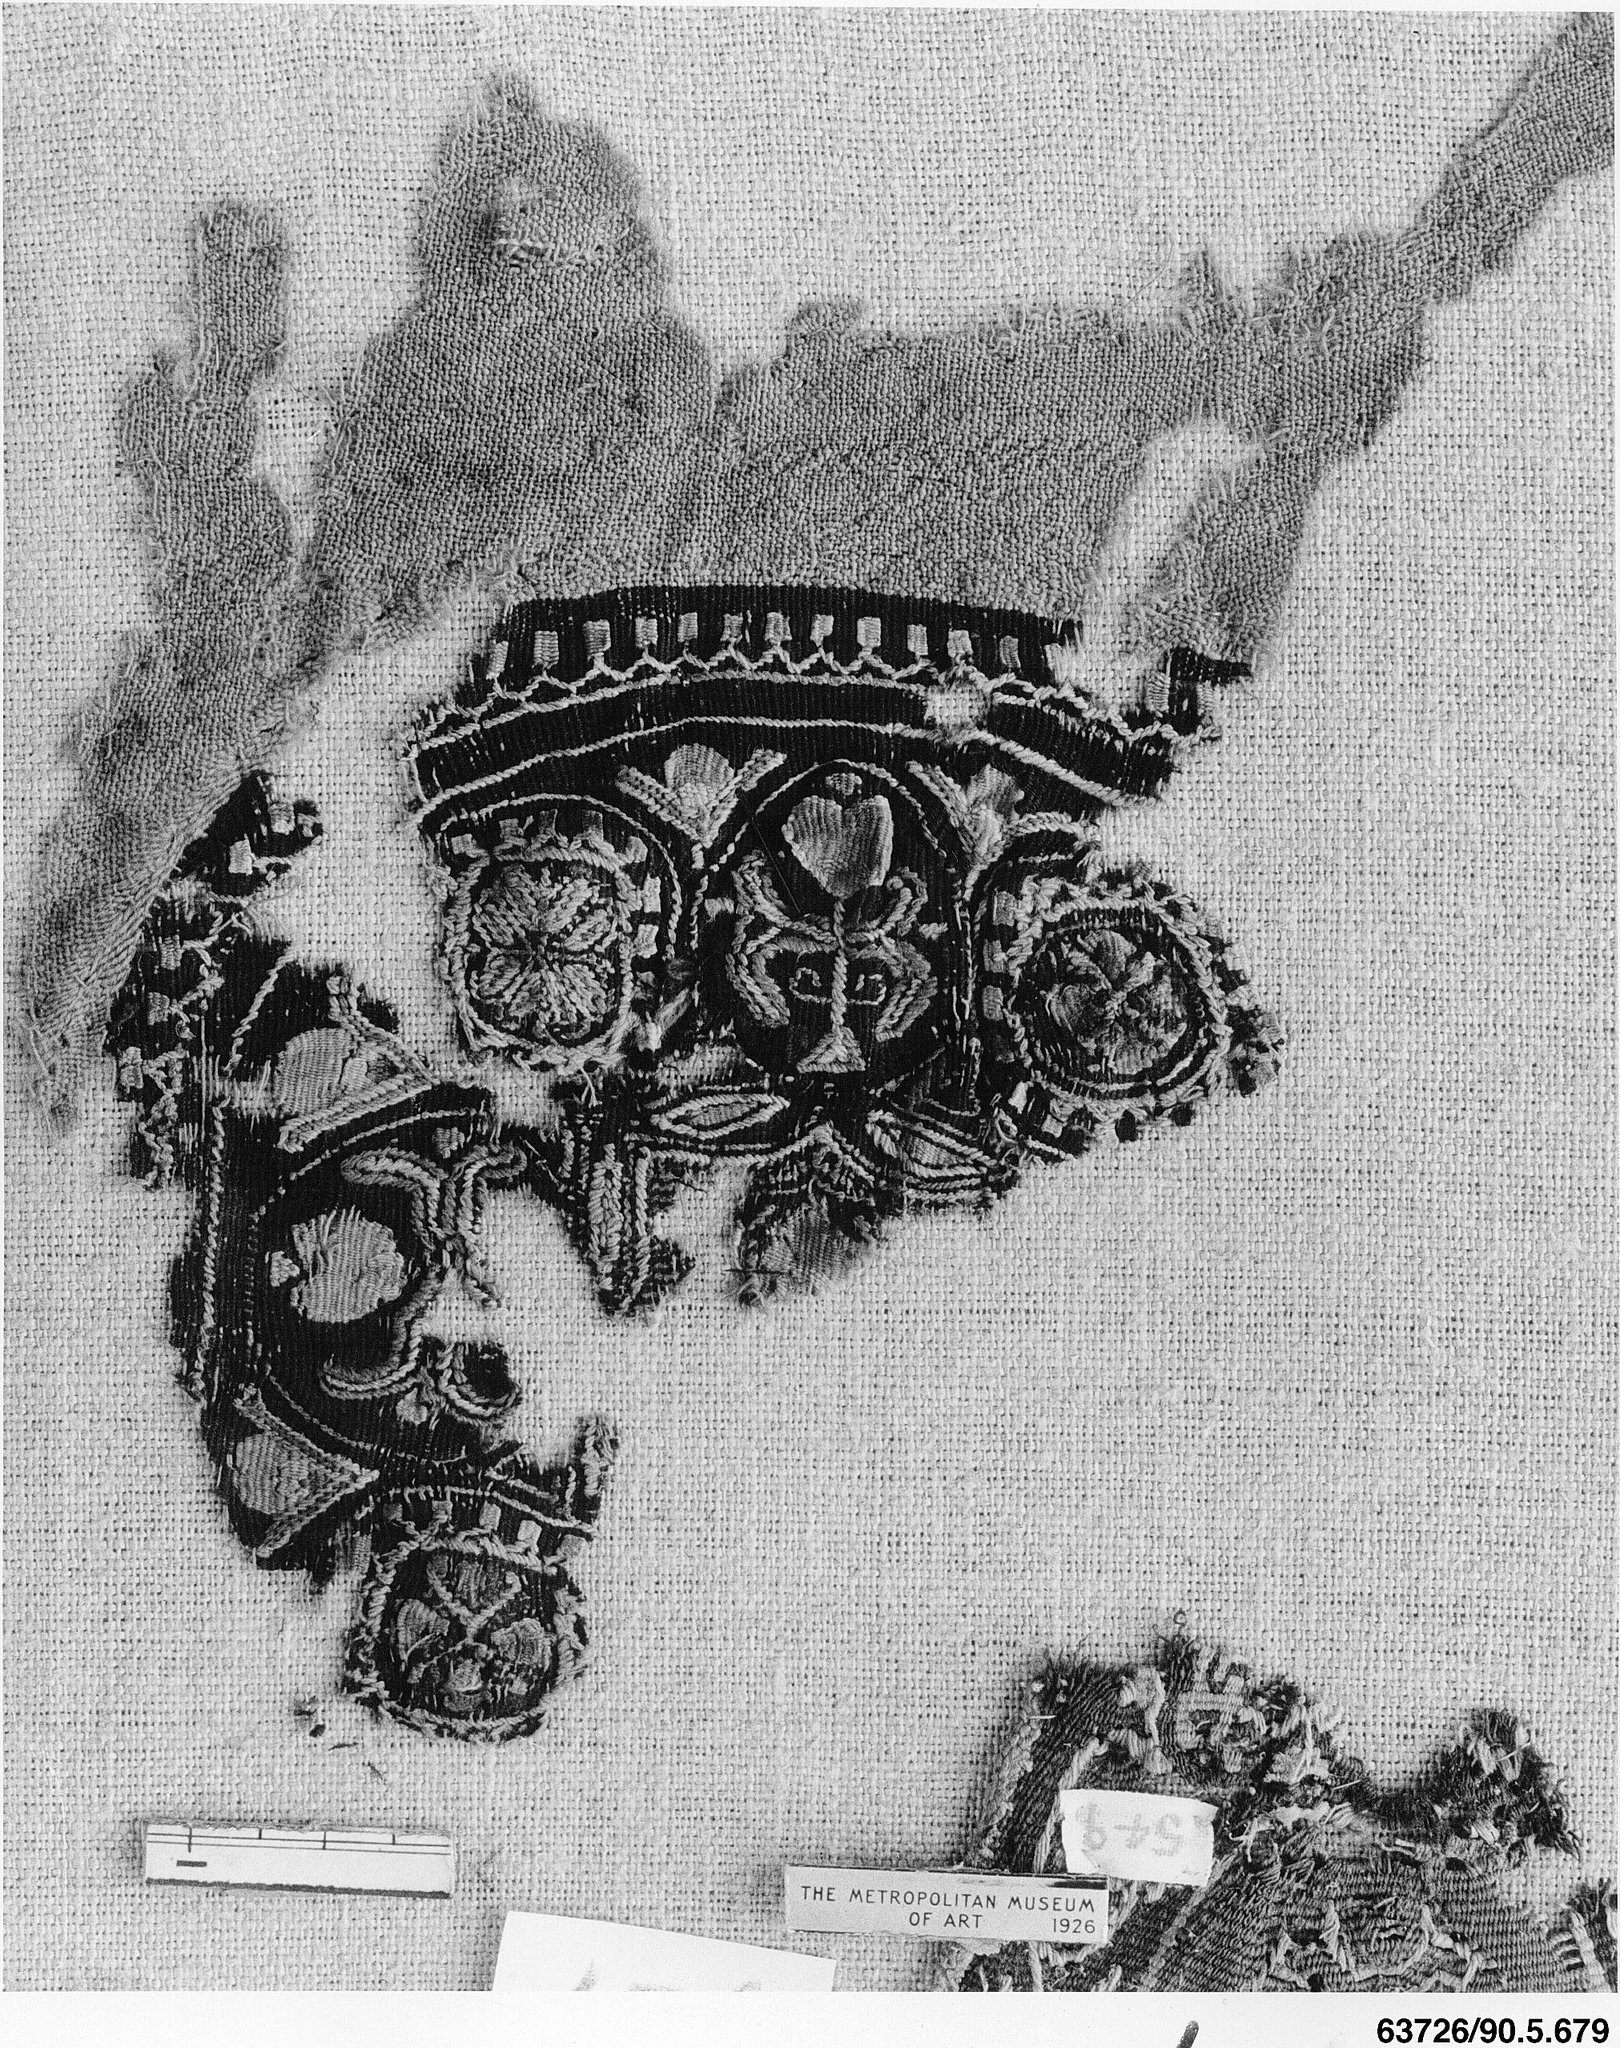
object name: textile fragment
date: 401-600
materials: linen, wool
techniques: weave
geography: egypt